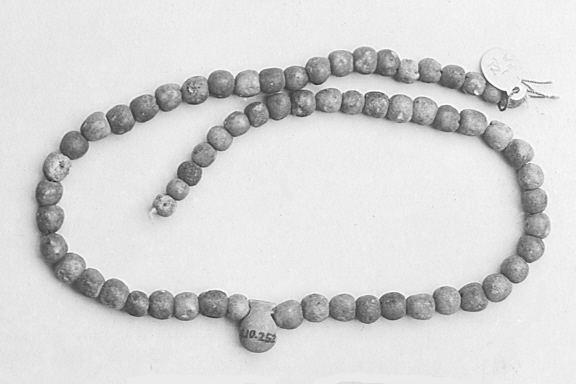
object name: necklace, bead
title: Necklace of Ball Beads and a Vase Amulet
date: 2040-1640 BCE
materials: faience, marble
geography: egypt